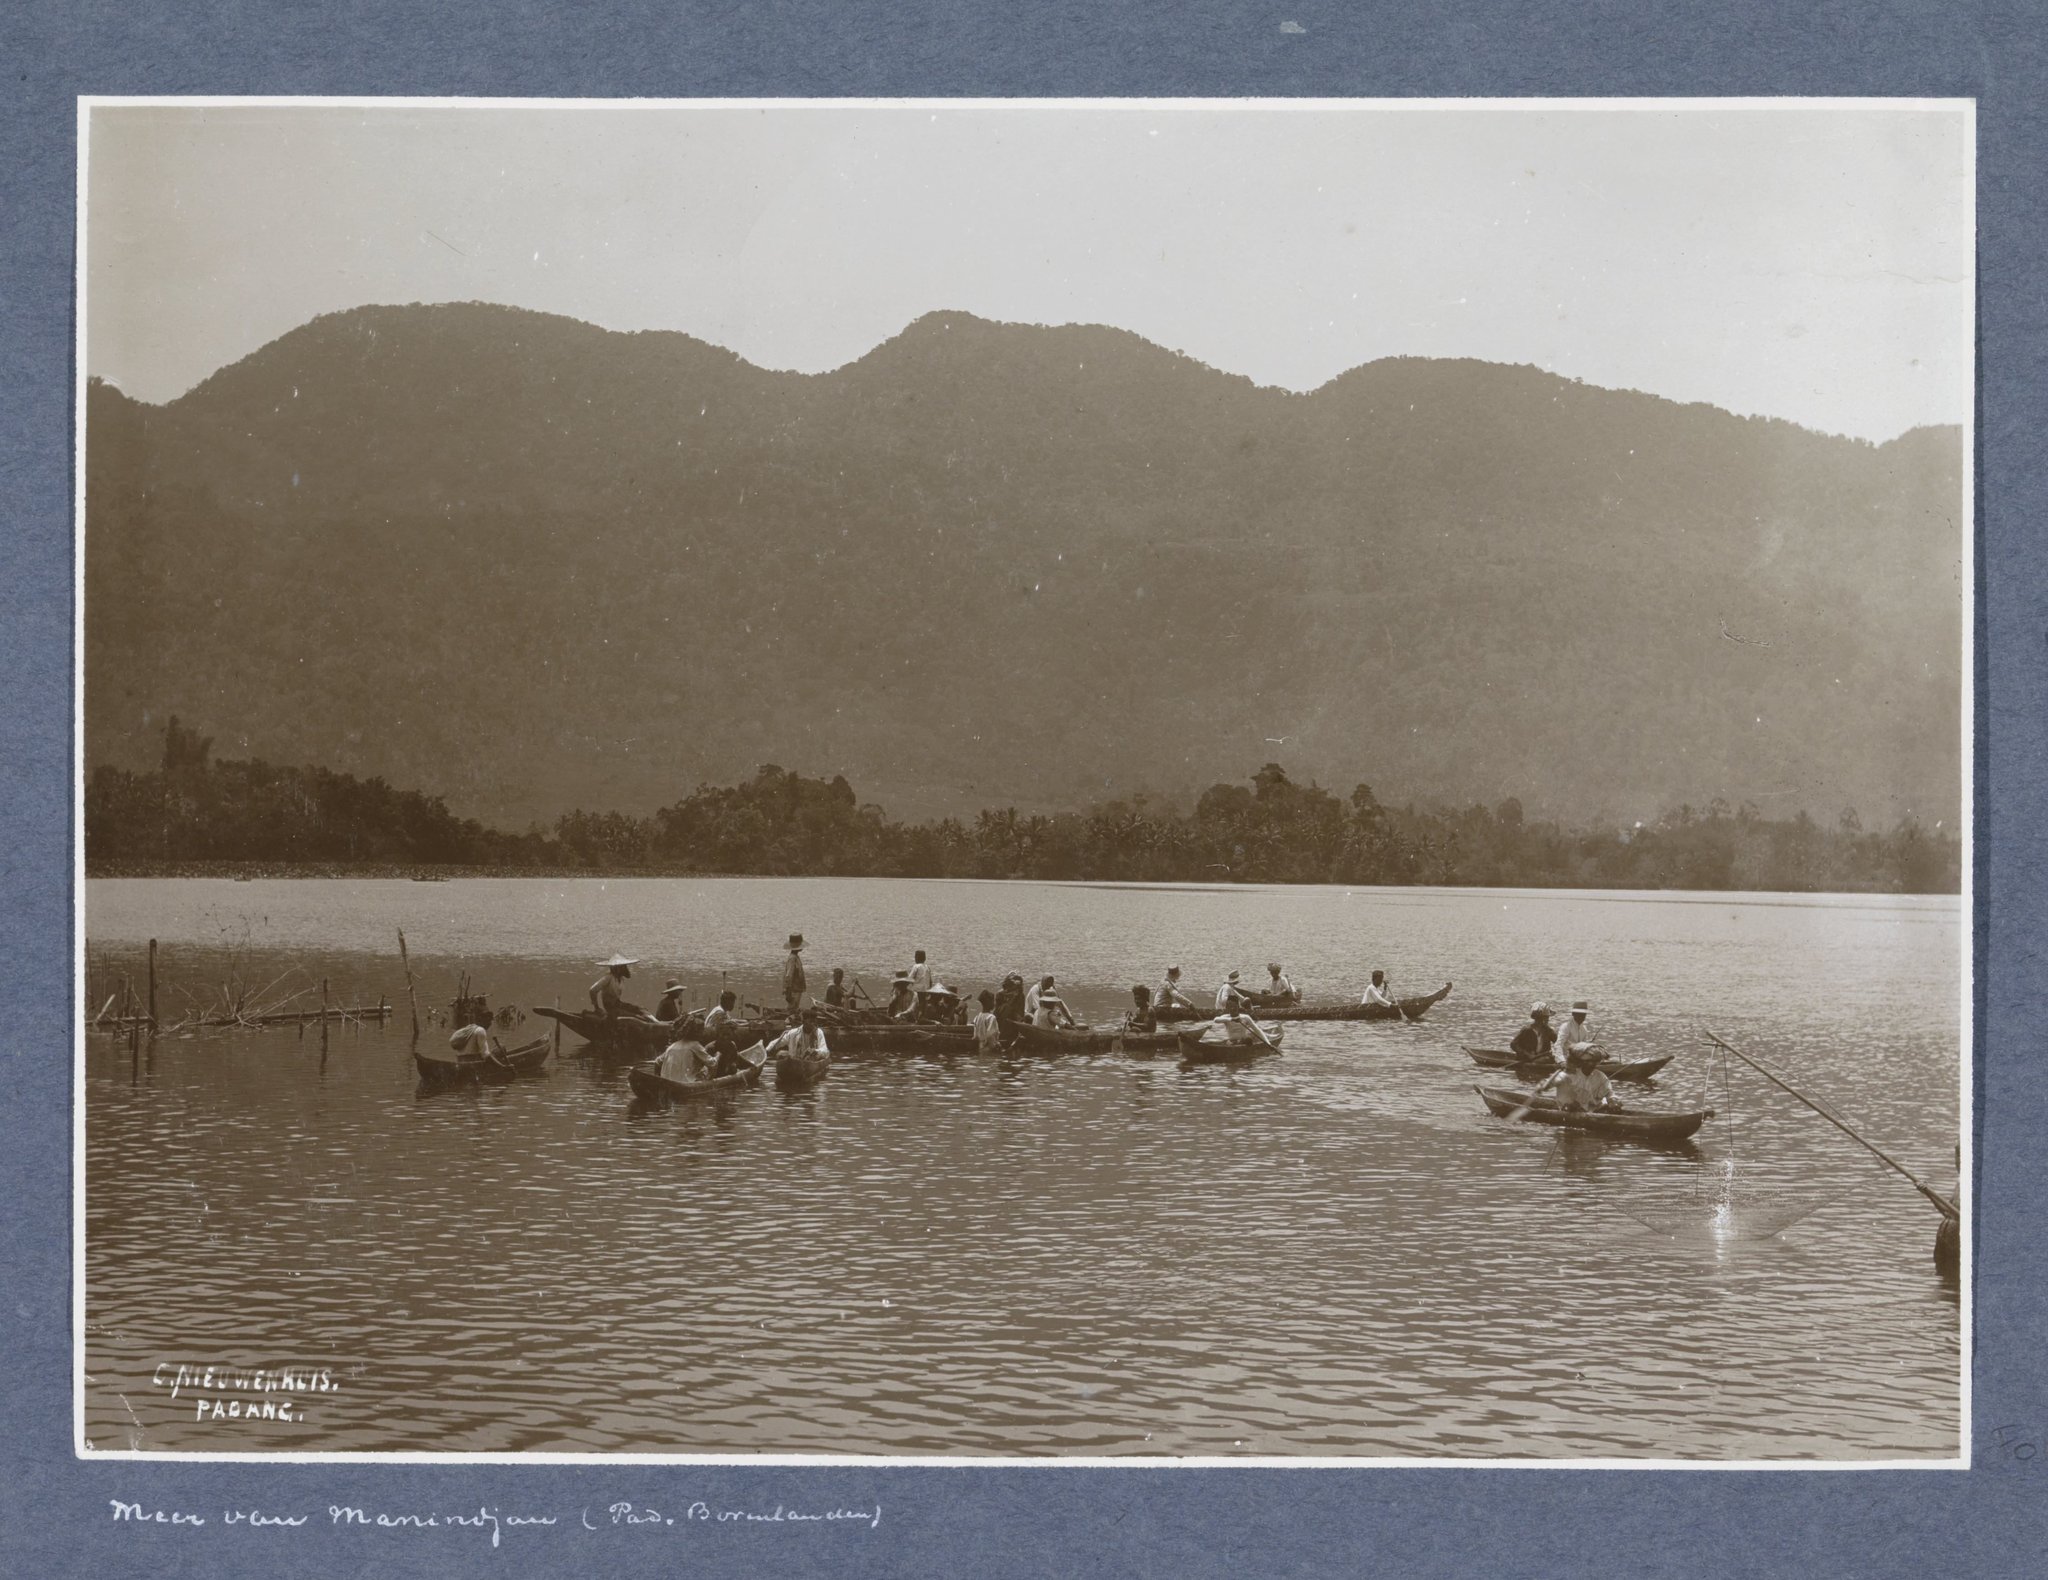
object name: album leaf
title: Gezicht op het Meer van Manindjau op Sumatra met vissers in kano's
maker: christiaan benjamin nieuwenhuis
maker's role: publisher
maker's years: 1863-1922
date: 1900-1920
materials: paper, photographic support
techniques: gelatin silver print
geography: sumatra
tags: fishing net, lake, fisherman, sumatra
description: Onderdeel van reisalbum met foto's van bedrijvigheid en bezienswaardigheden op Sumatra en Java en van de reis naar en van Nederlands-Indië.